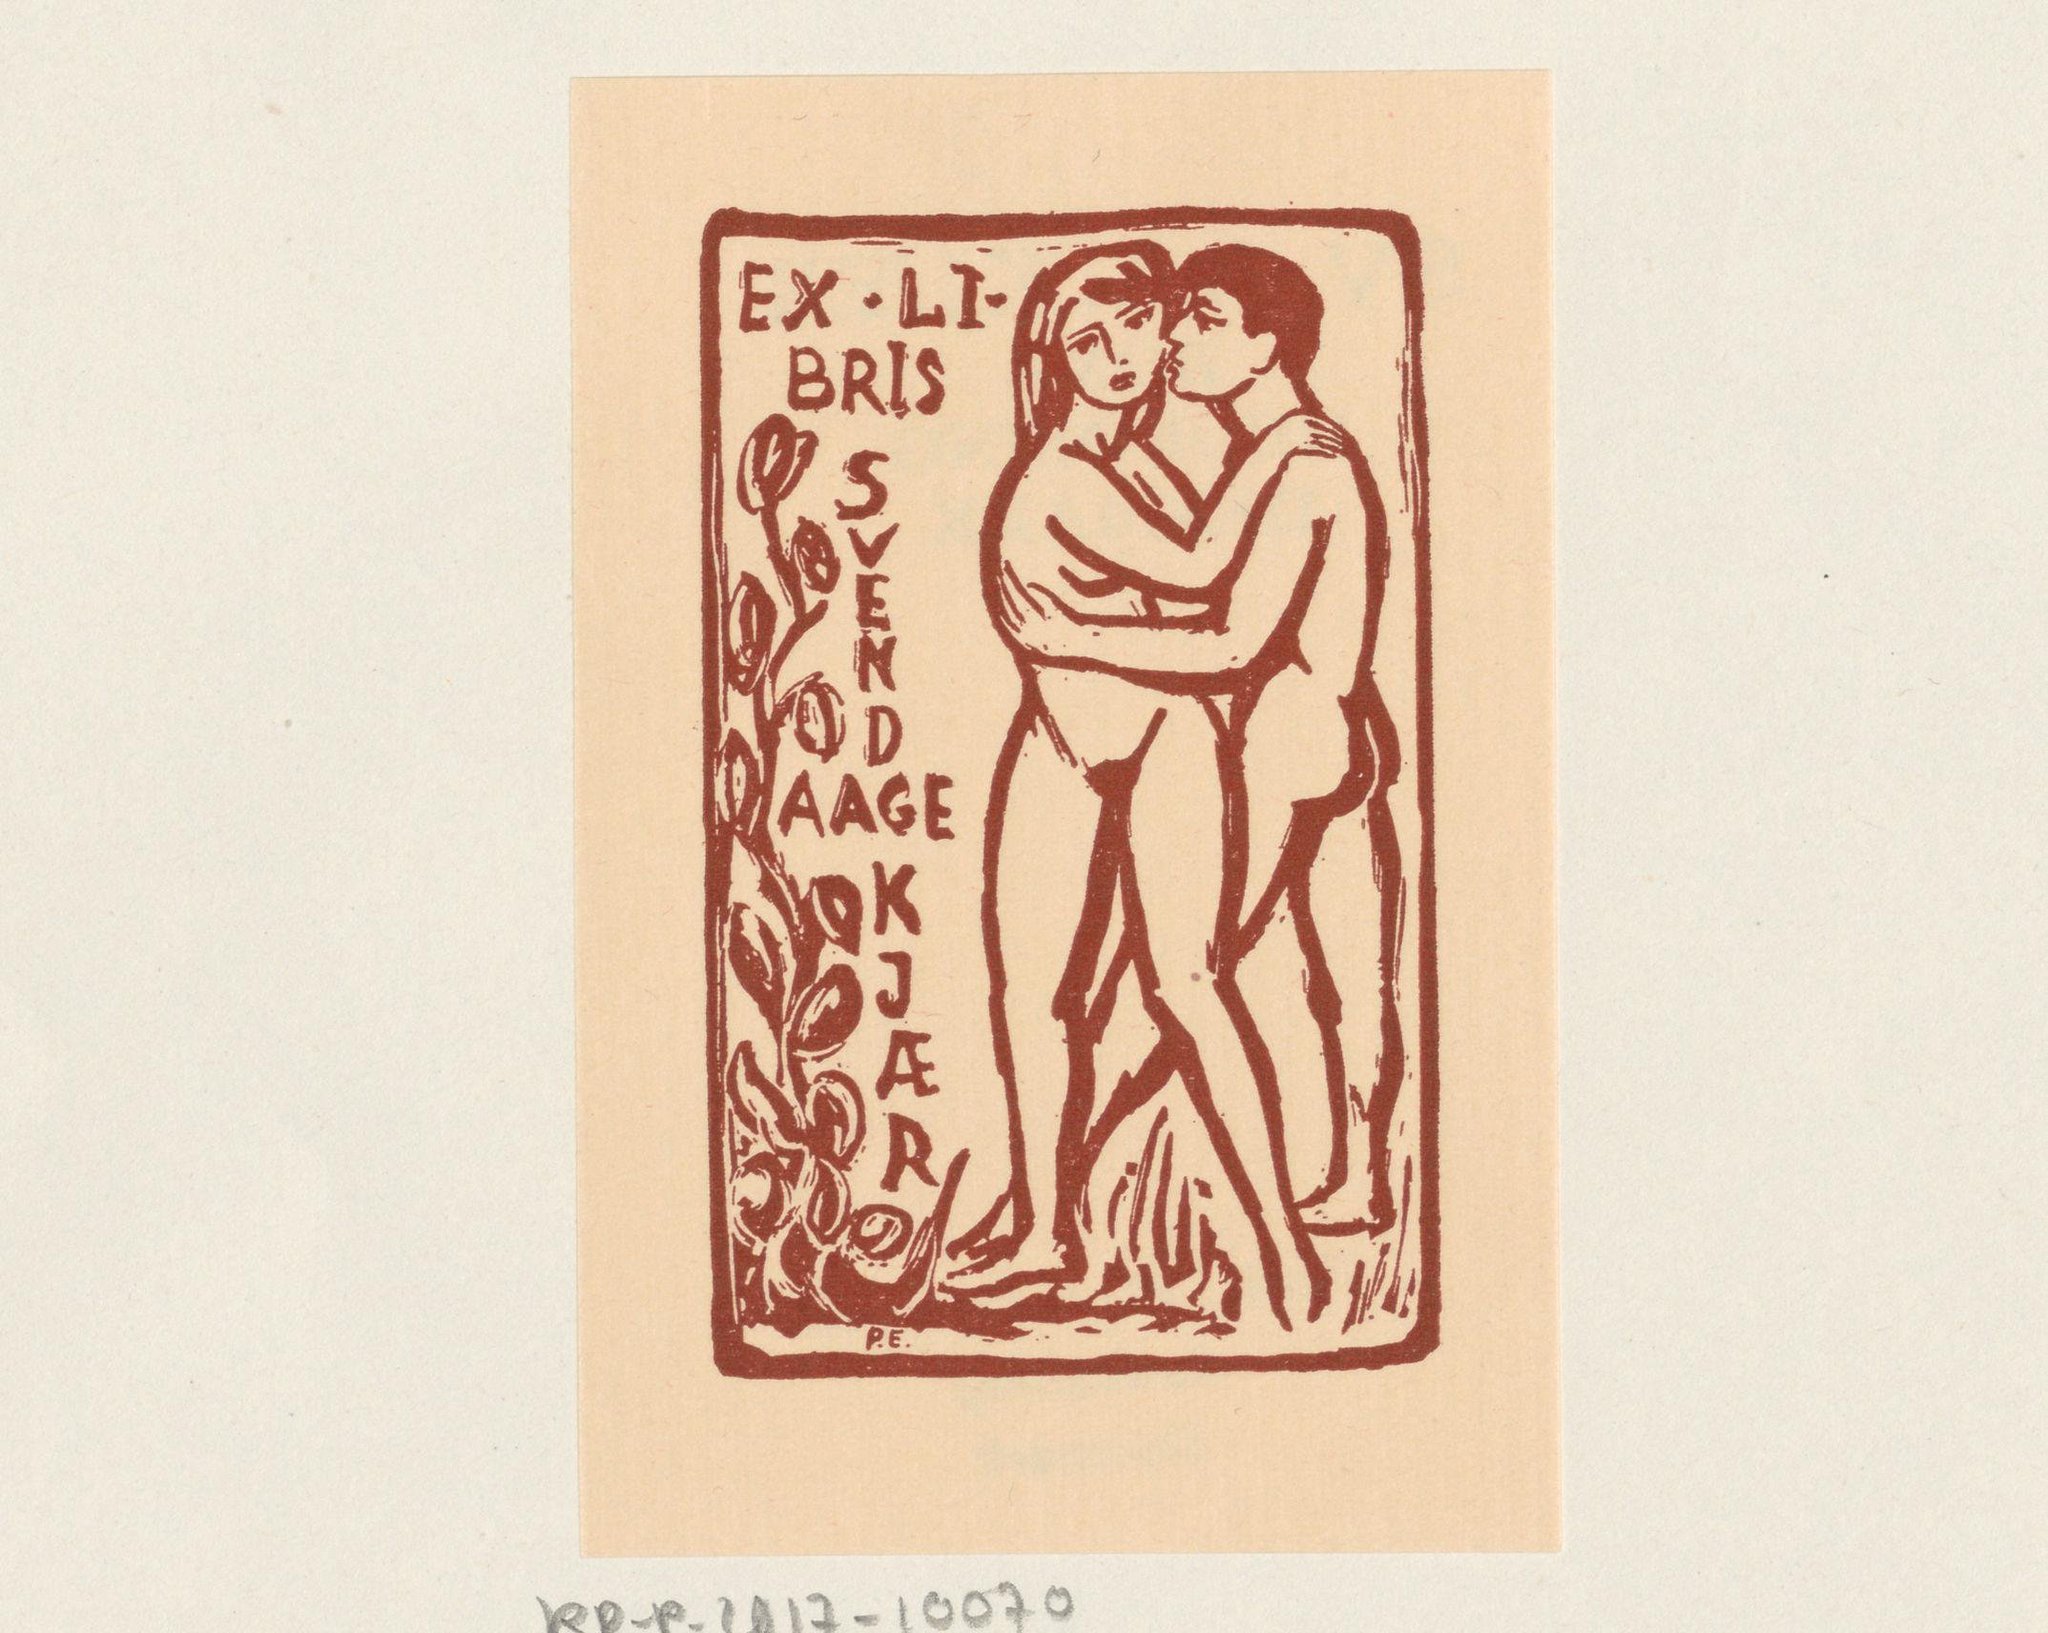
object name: bookplate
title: Ex libris van Svend Aage Kjær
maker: poul egebæk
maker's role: print maker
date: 1900-1999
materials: paper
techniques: linocut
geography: rudkøbing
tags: woman (showing herself) undressed, quasi-nude, couple of lovers, man (showing himself) undressed, quasi-nude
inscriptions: stamp: ‘Sv. Aa. Kjær/ Box 8/ Rudkøbing/ Denmark’, workshop stamp: ‘Fecit: Poul Egebaek/ Rudkøbing/ Danmark’